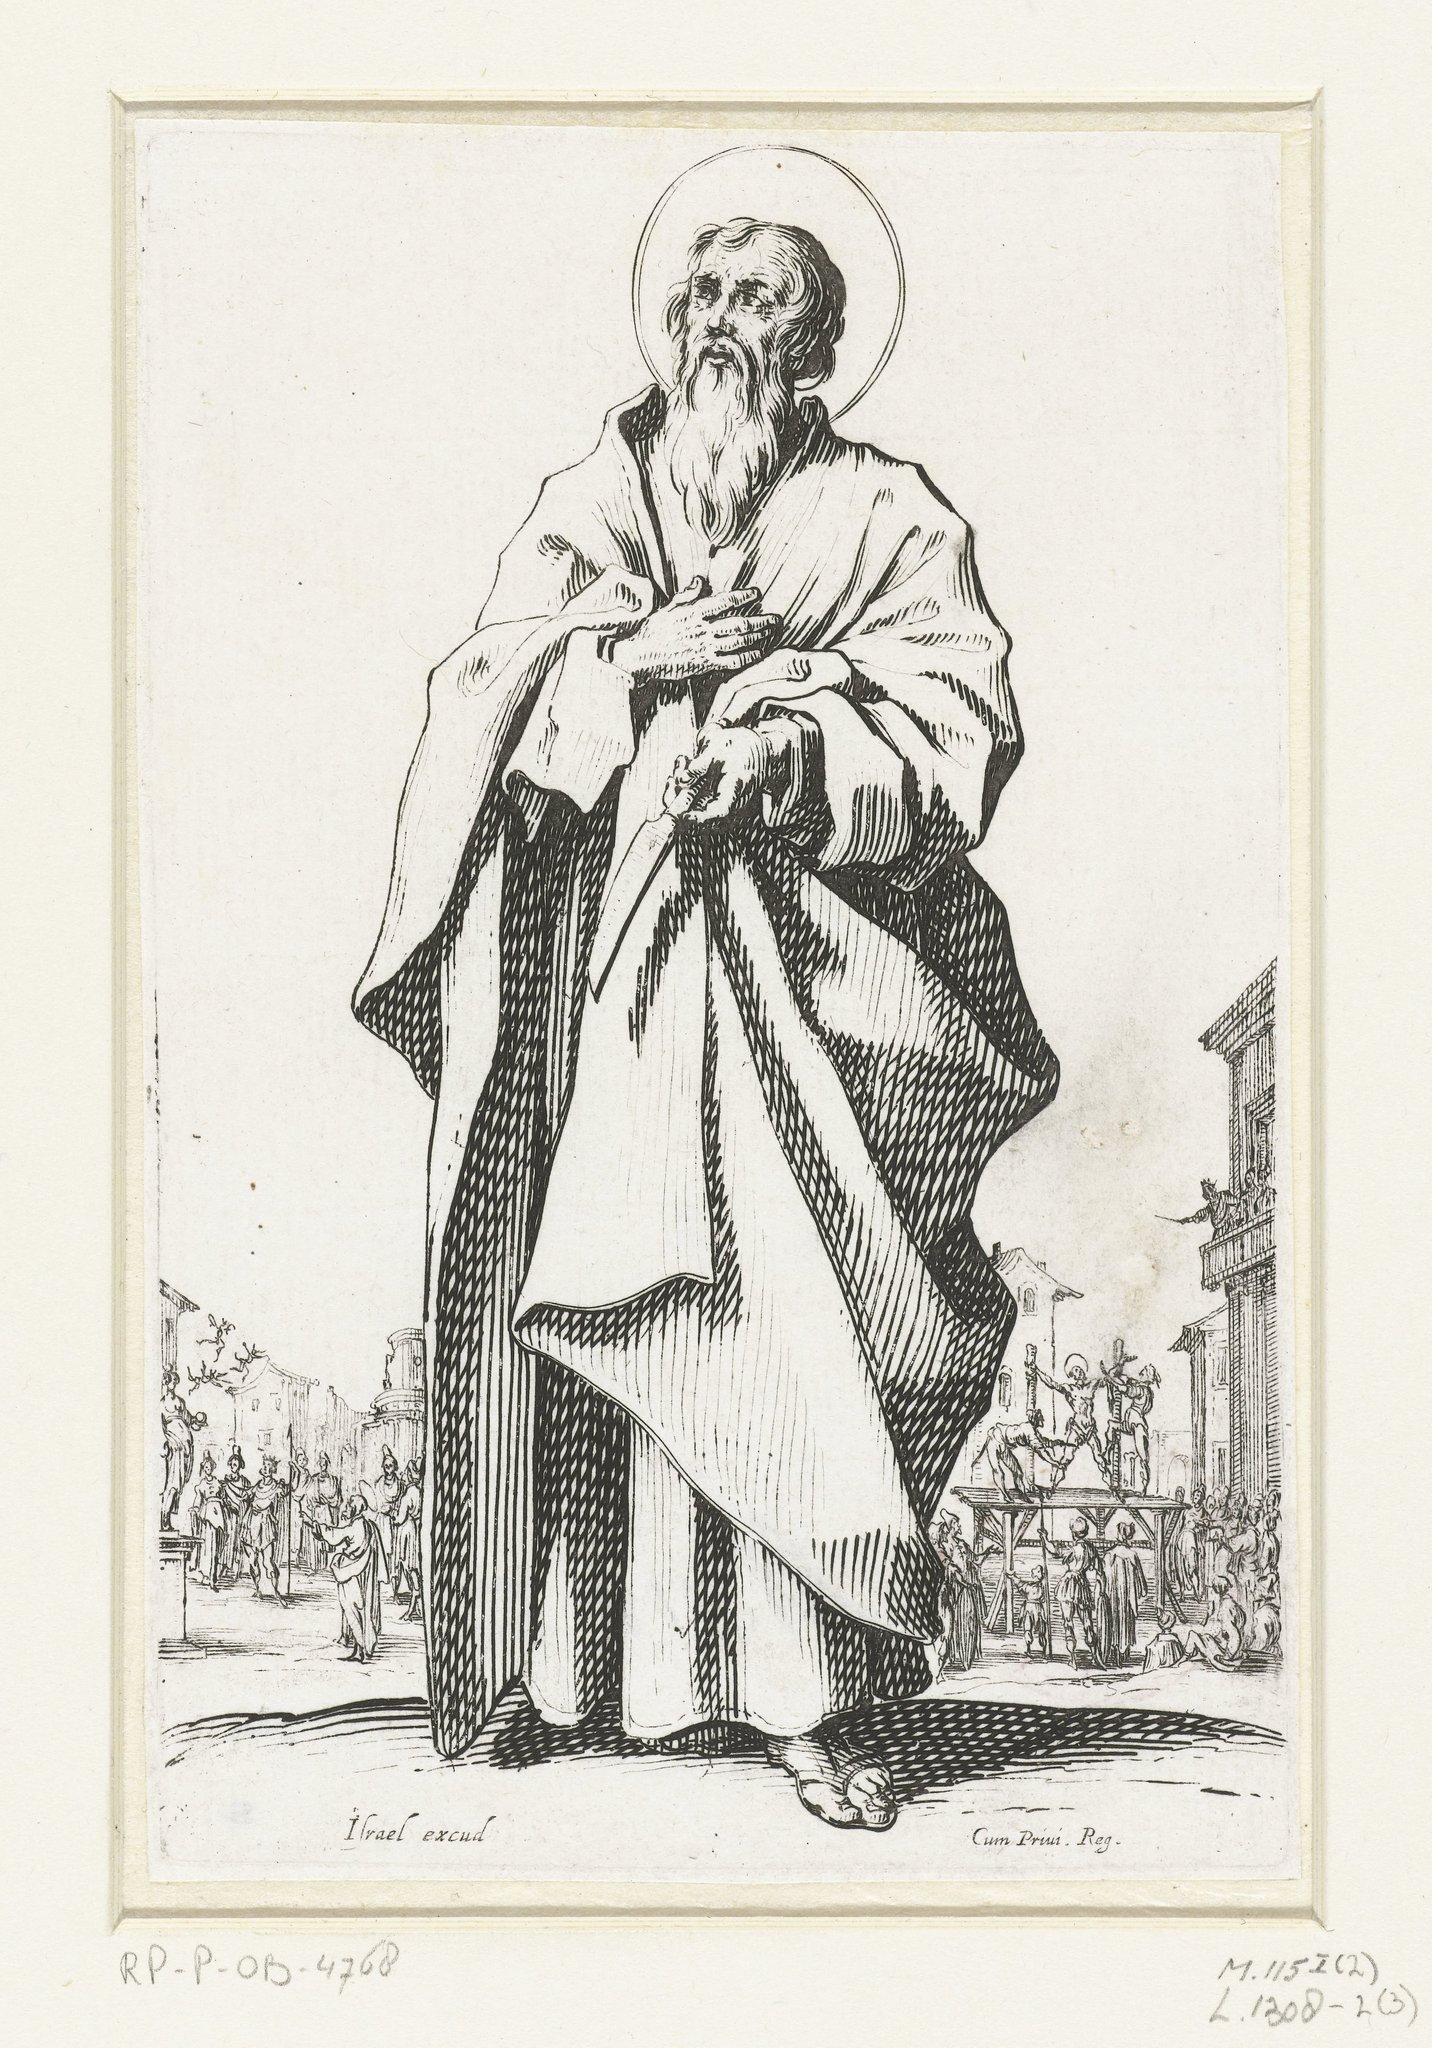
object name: print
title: De grote apostelen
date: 1631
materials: paper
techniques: etching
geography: paris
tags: the apostle bartholomew; possible attributes: book, devil or dragon at feet, knife, scroll, flayed skin, staff, bartholomew flayed alive, bartholomew casting a demon out of a woman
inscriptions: collector's mark: Lugt 240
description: Bartholomeüs, ten voeten uit, een mes in de hand. Op de achtergrond links is te zien hoe hij boze geesten uitdrijft; op de achtergrond rechts is te zien hoe hij wordt gevild. Deze prent is onderdeel van een reeks van 16 prenten, bestaande uit een titelblad en 15 portretten, voorstellende Christus, Maria en de apostelen.